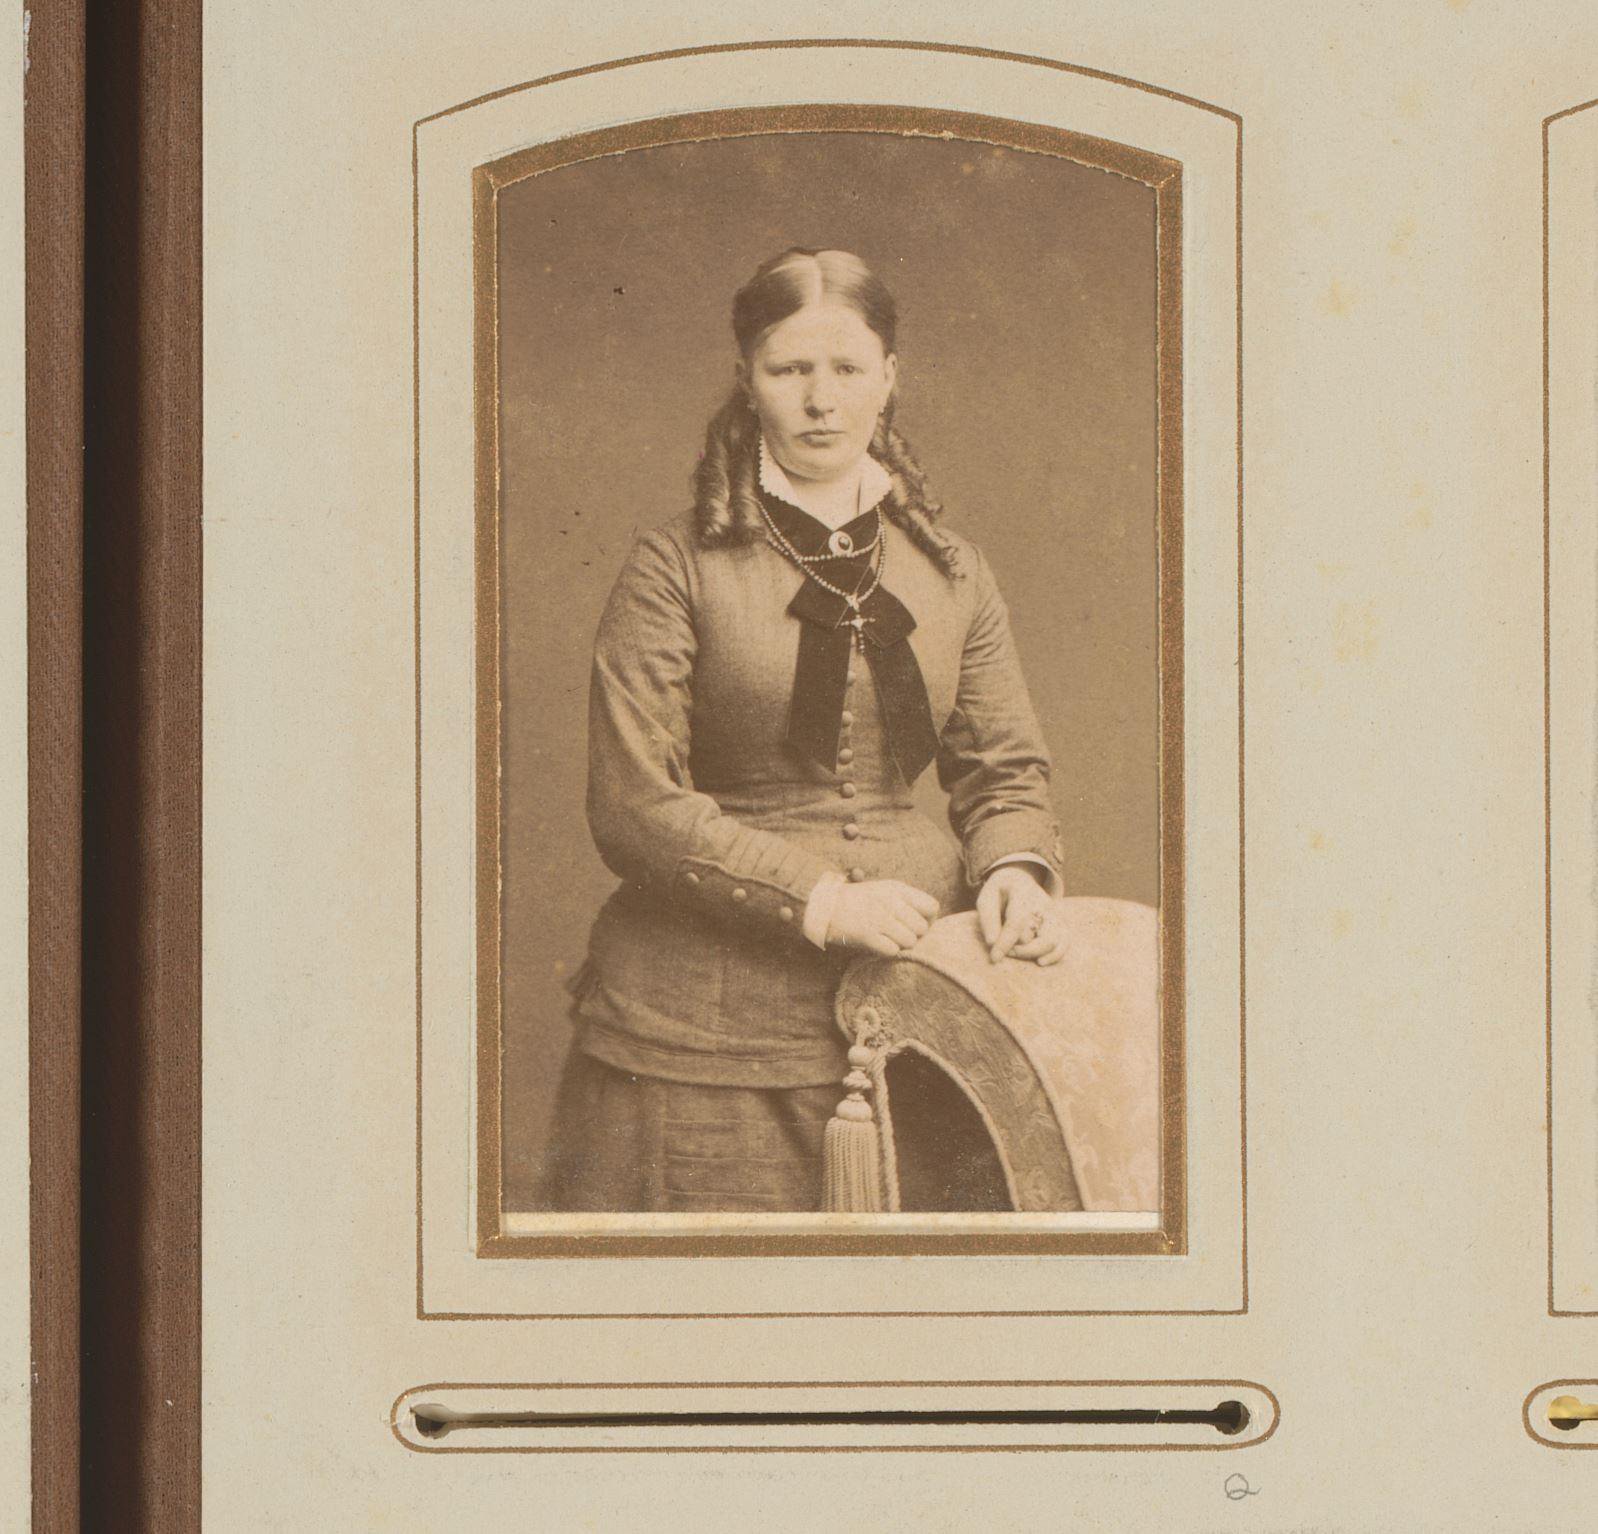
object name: carte de visite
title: Portret van een jonge vrouw met pijpenkrullen, staand bij een stoel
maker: albert greiner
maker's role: fotograaf, fotostudio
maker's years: 1833-1890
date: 1861-1887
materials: cardboard, photographic support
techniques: albumen print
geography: amsterdam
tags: adolescent, young woman, maiden, historical persons - bb - woman, hairdress, chair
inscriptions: inscription: ‘A. GREINER/ Photograf/ AMSTERDAM/ NIEUWENDIJK L. 89.’